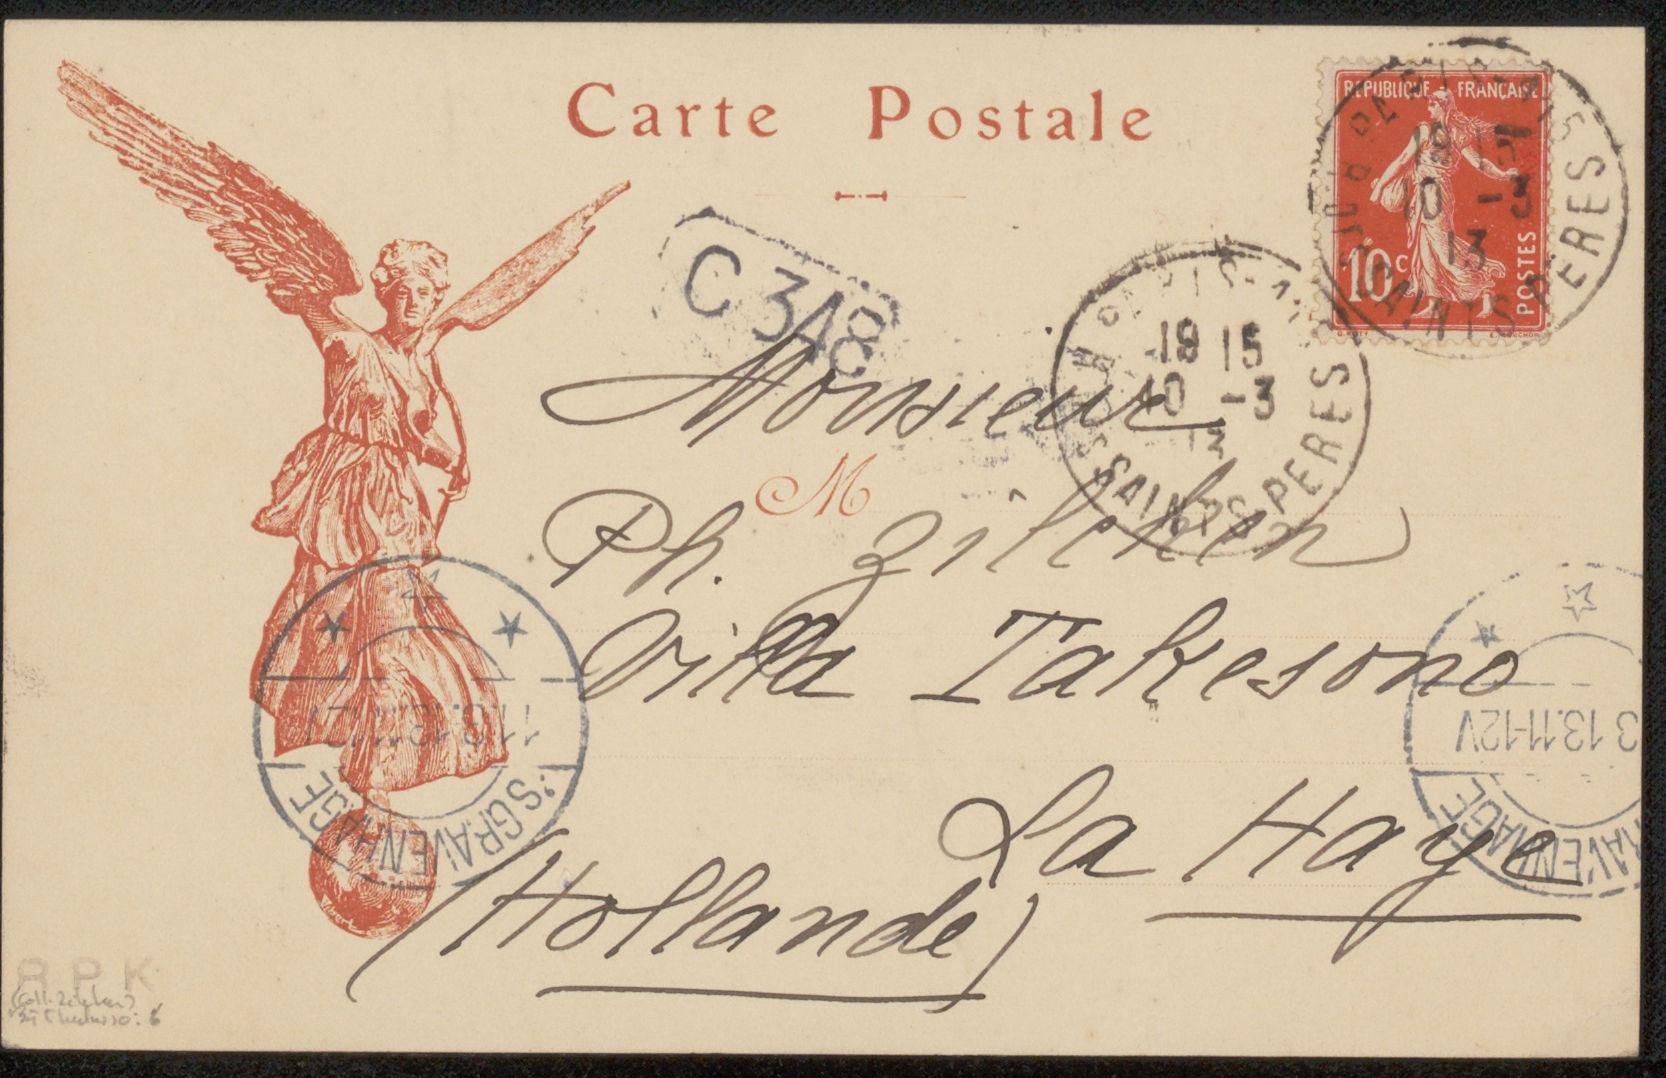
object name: postcard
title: Briefkaart aan Philip Zilcken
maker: adolphe thalasso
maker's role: criticus, dichter, dramaturg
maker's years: 1858-1919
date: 1913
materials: cardboard, ink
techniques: pen, printing, writing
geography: paris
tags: armand dayot, the hague, painter, philip zilcken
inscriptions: collector's mark: ‘RPK’